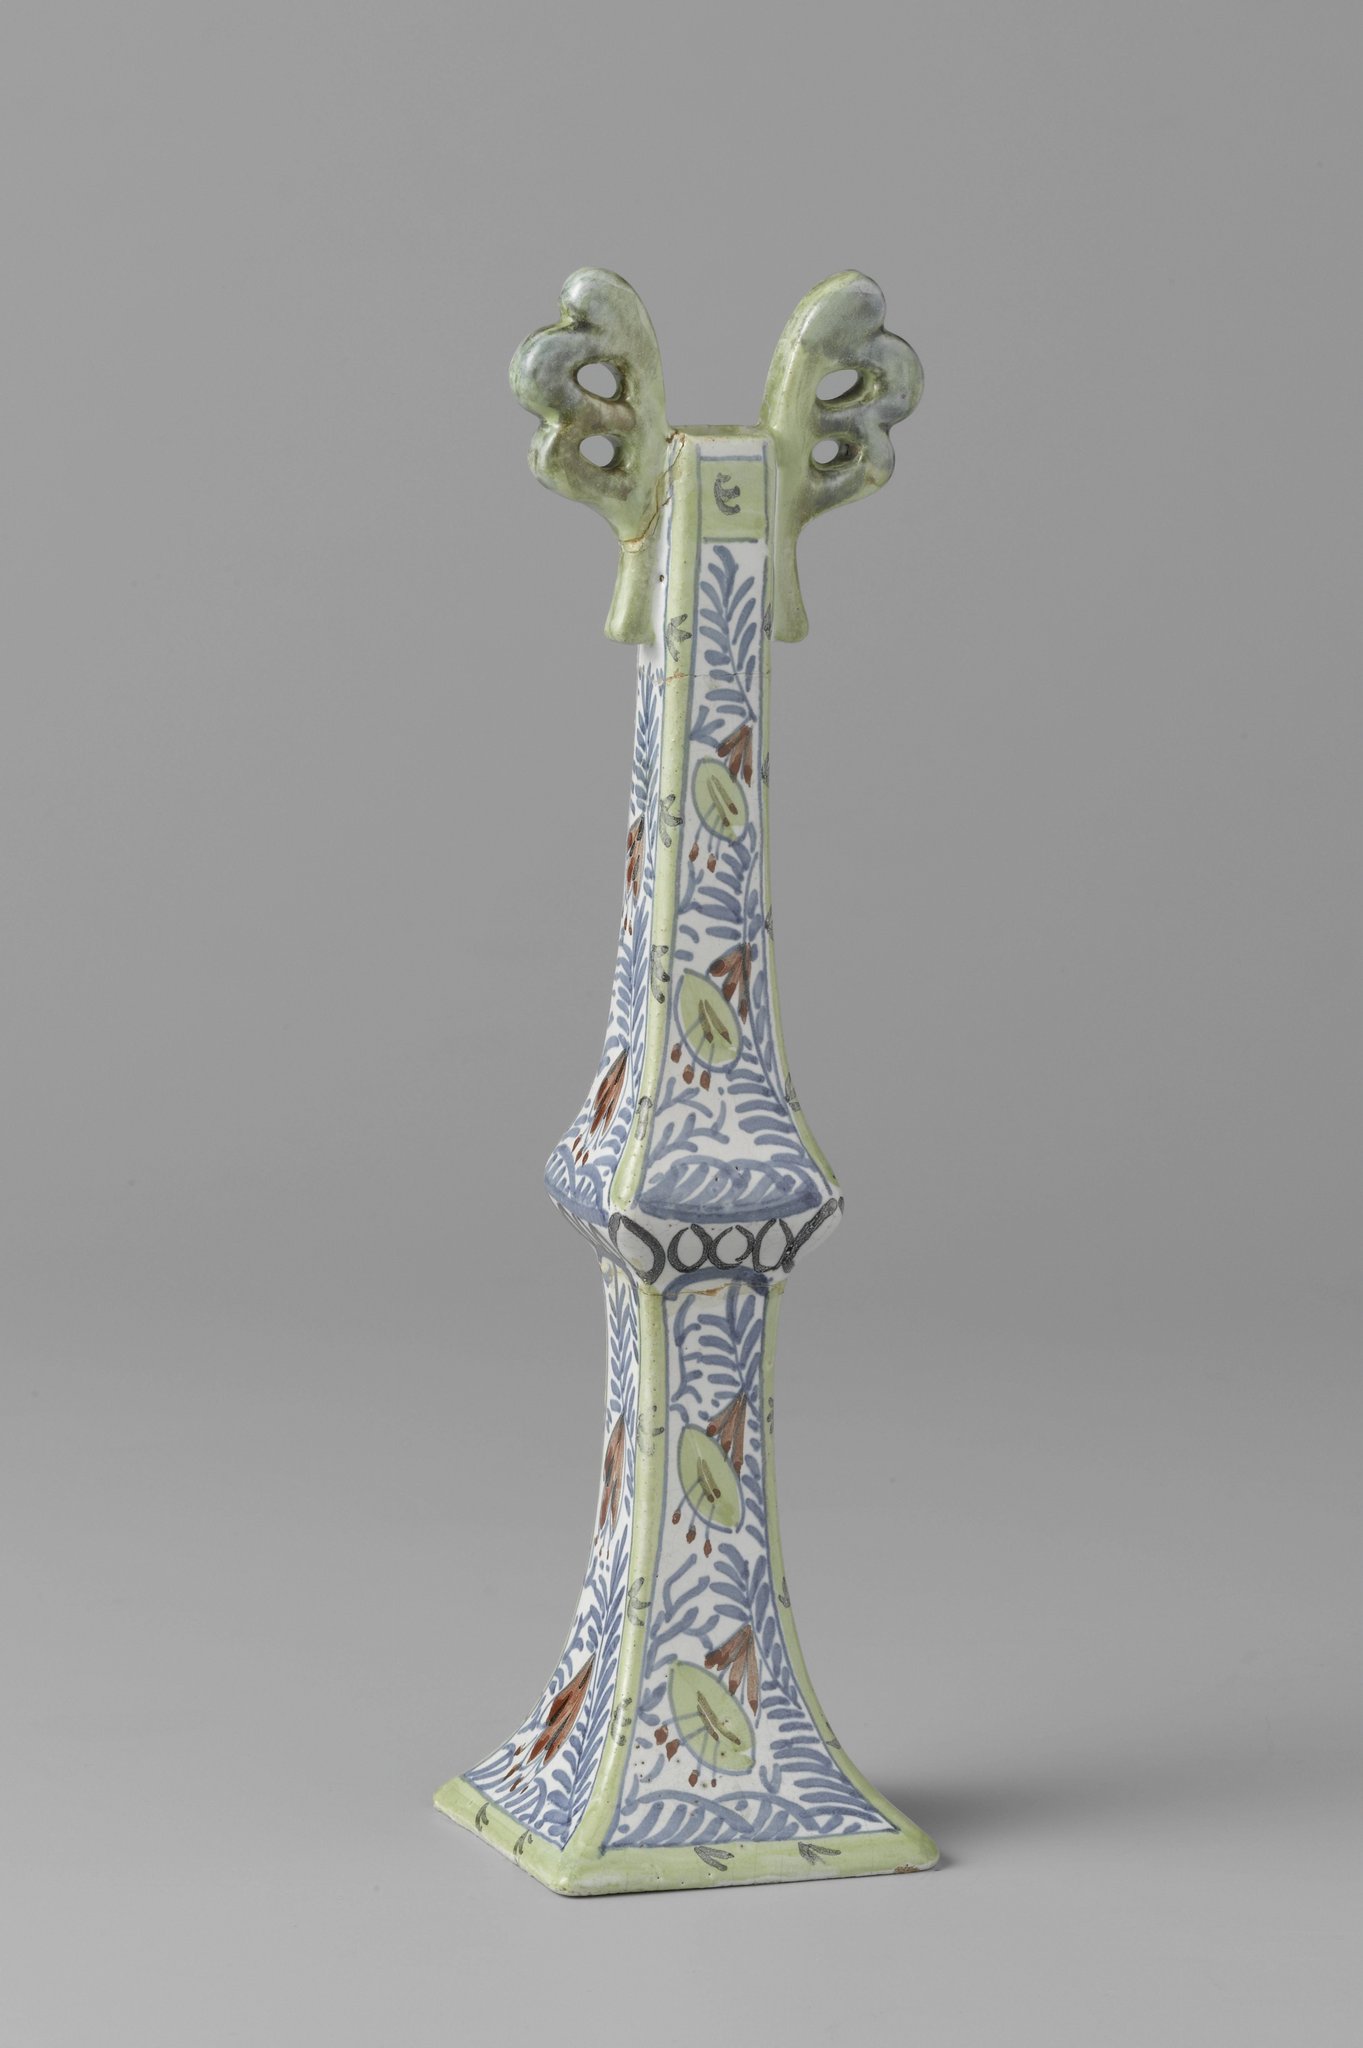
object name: vase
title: Vaas met gestileerde bloem- en bladversiering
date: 1880-1920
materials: earthenware, glaze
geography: delft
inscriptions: mark: ‘fles // F // Delft’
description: Vaas van aardewerk, vierkante voet en zich verjongende stam met vierkante nodus. Bovenste deel van de stam wordt nog smaller en wordt aan weerszijden bekroond door twee opengewerkte ornamenten. Beschilderd met gestileerd bloem- en bladwerk in de kleuren blauw, groen en rood.